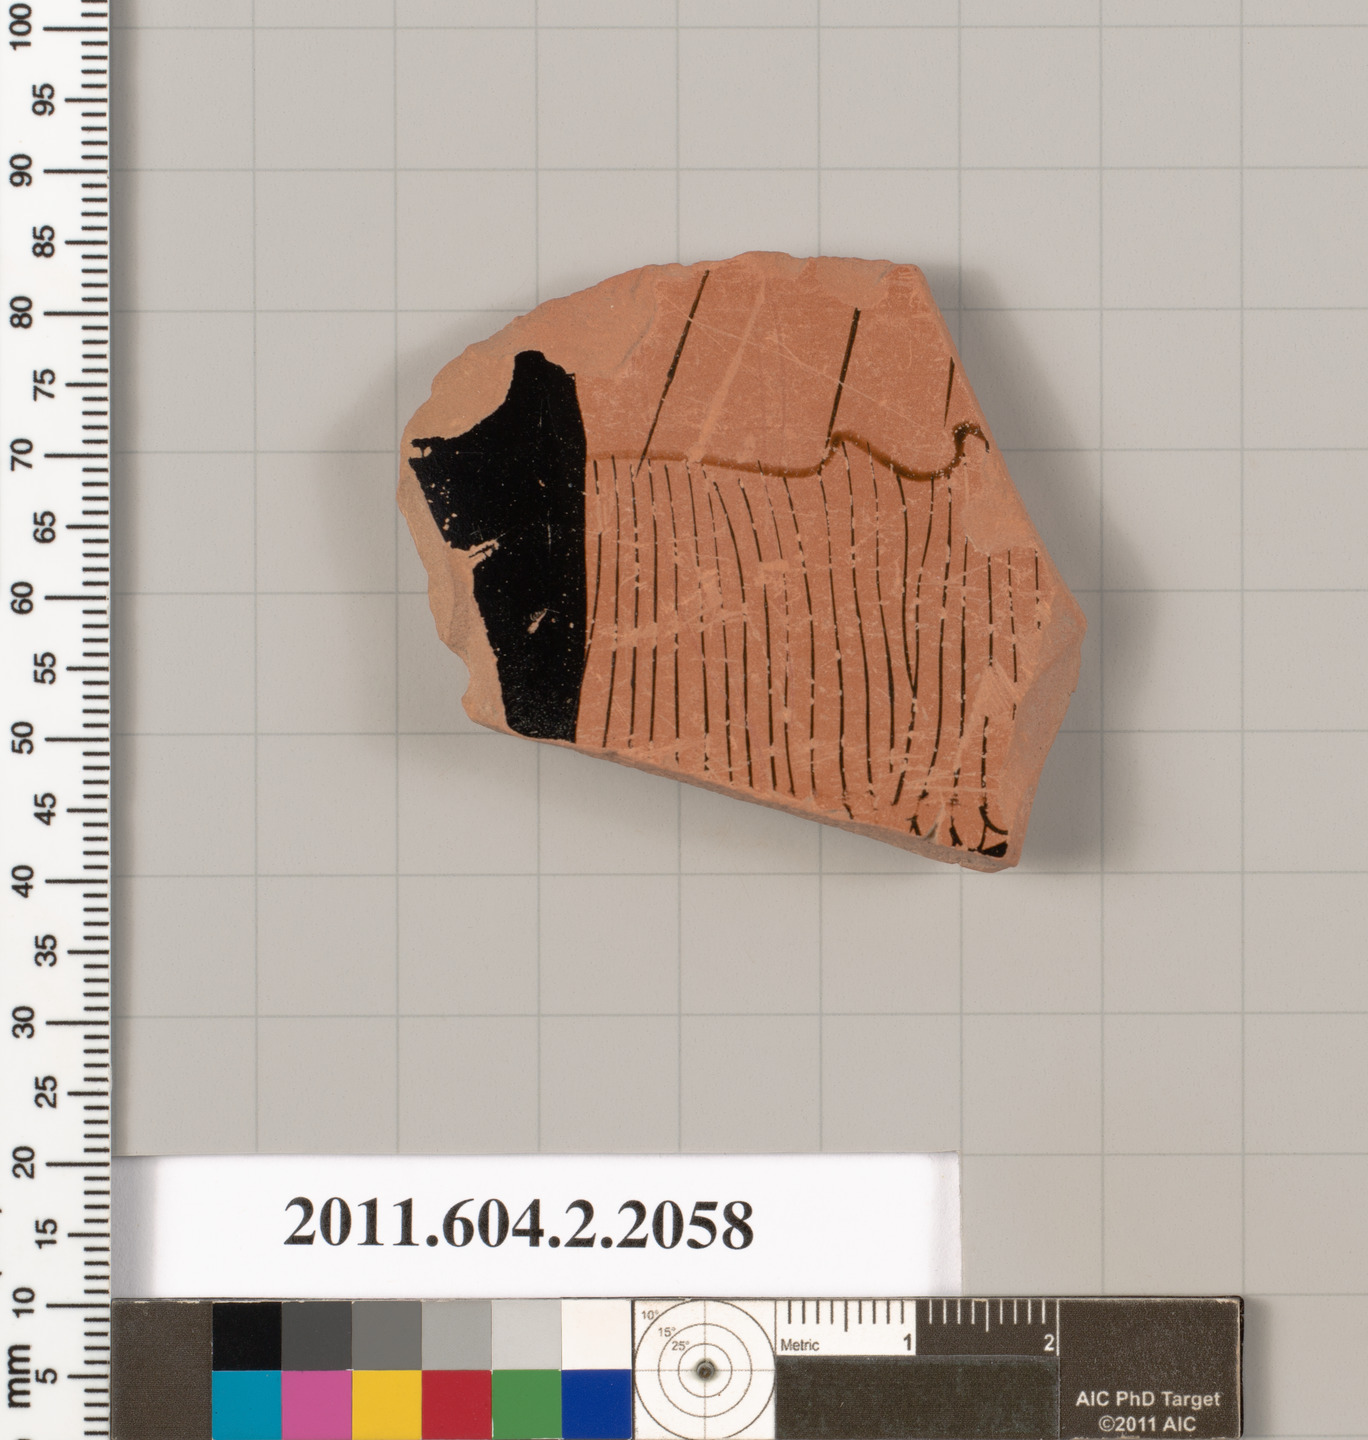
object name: krater fragment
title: Terracotta fragment of a krater (bowl for mixing wine and water)?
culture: greek, attic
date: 475-451 BCE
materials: terracotta